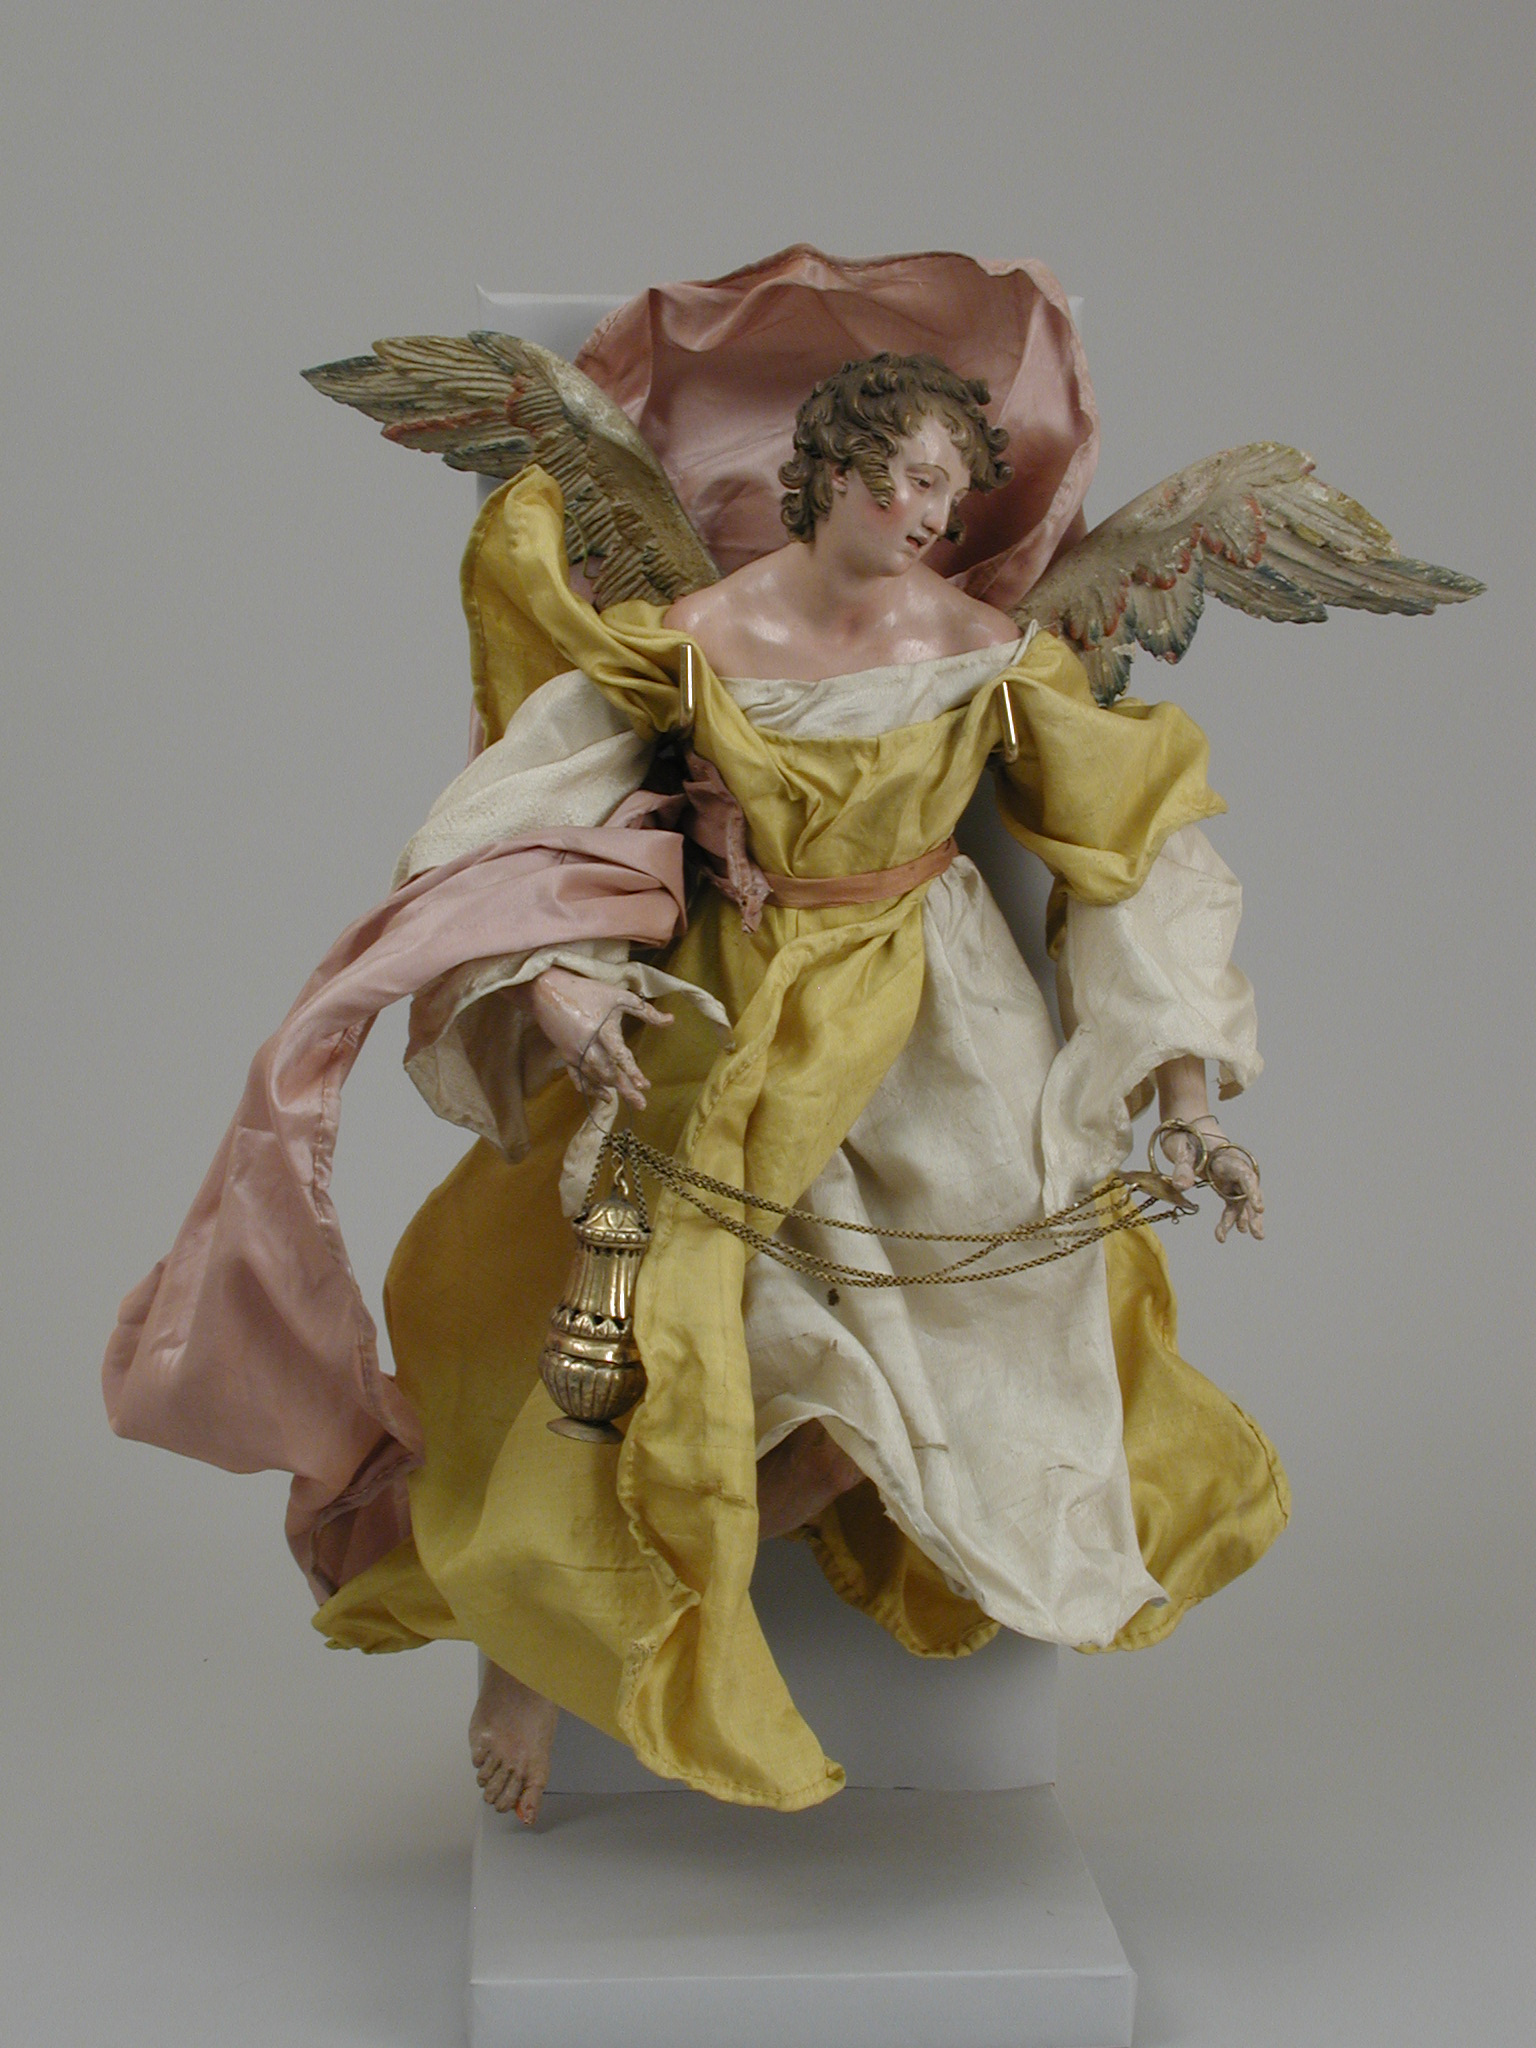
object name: crèche figure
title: Angel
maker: giuseppe sanmartino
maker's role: maker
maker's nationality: italian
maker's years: 1720-1793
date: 1751-1800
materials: terracotta, fiber, metal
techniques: polychrome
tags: angels,censers